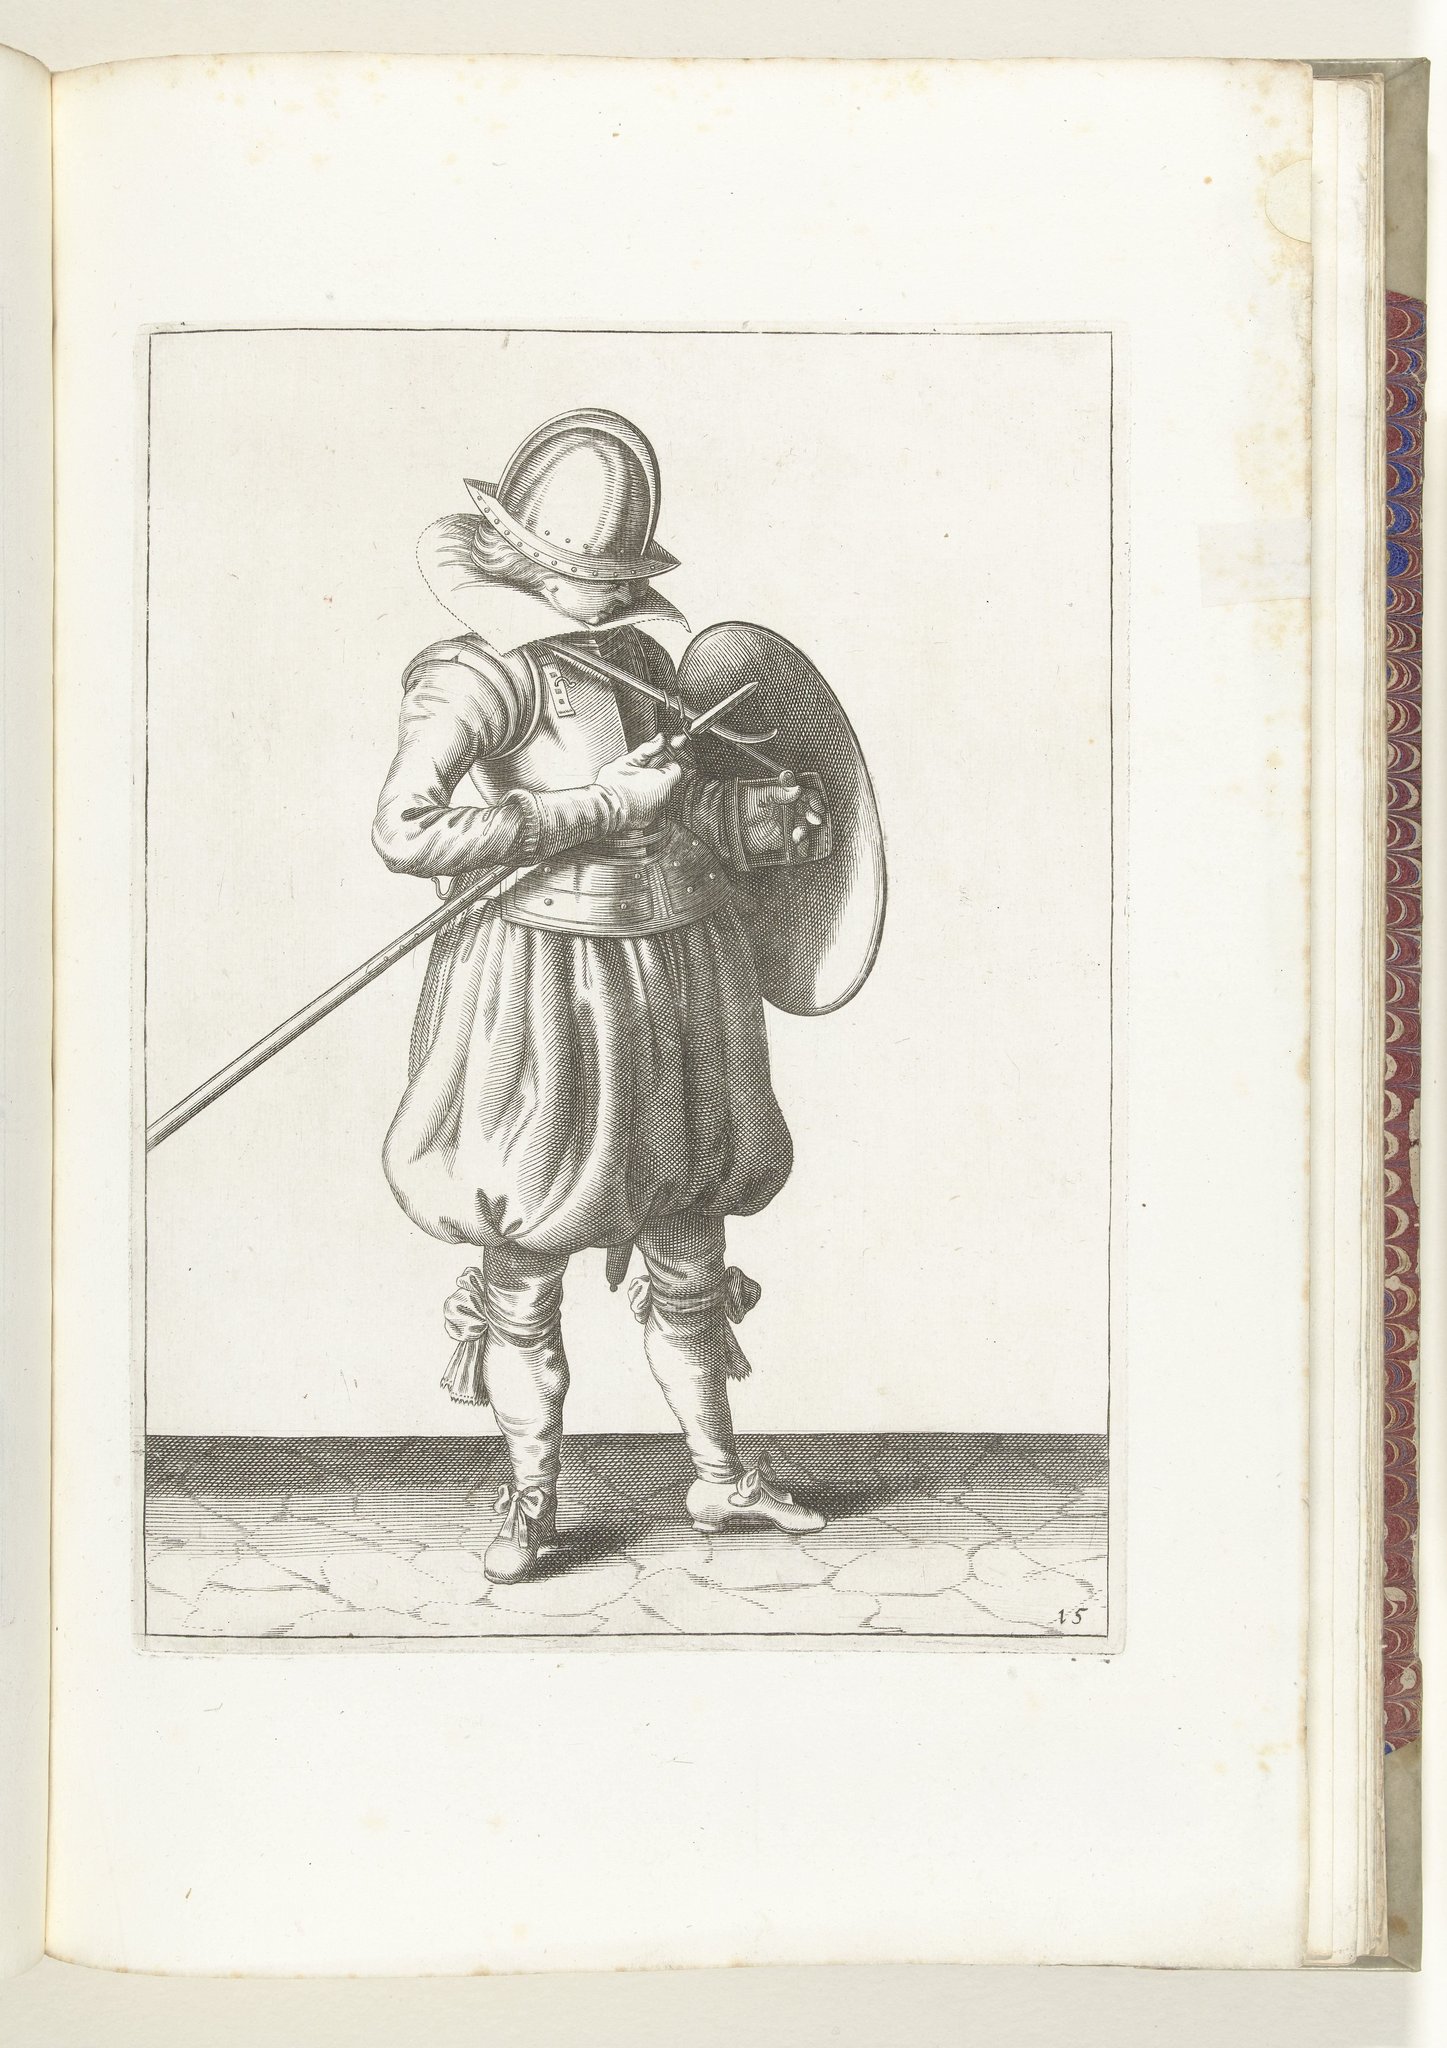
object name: print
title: De Nassausche Wapen-Handelinge, van Schilt, Spies, Rappier ende Targe : beyde figuerlick afgebeelt, ende gestelt na de nieu ordening [van] (...) Maurits van Nassau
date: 1616-1618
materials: paper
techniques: engraving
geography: northern netherlands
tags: the hague, maurice (prince of orange), handling of weapons ~ military training, weapons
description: Illustratie in: Adam van Breen, De Nassausche Wapen-Handelinge, van Schilt, Spies, Rappier ende Targe : beyde figuerlick afgebeelt, ende gestelt na de nieu ordening [van] ... Maurits van Nassau, 's-Gravenhage, [Aert Meuris] 1618, plaat nr. 15. In het exemplaar in de collectie van de Rijksmuseum Research Library (326 F 22).